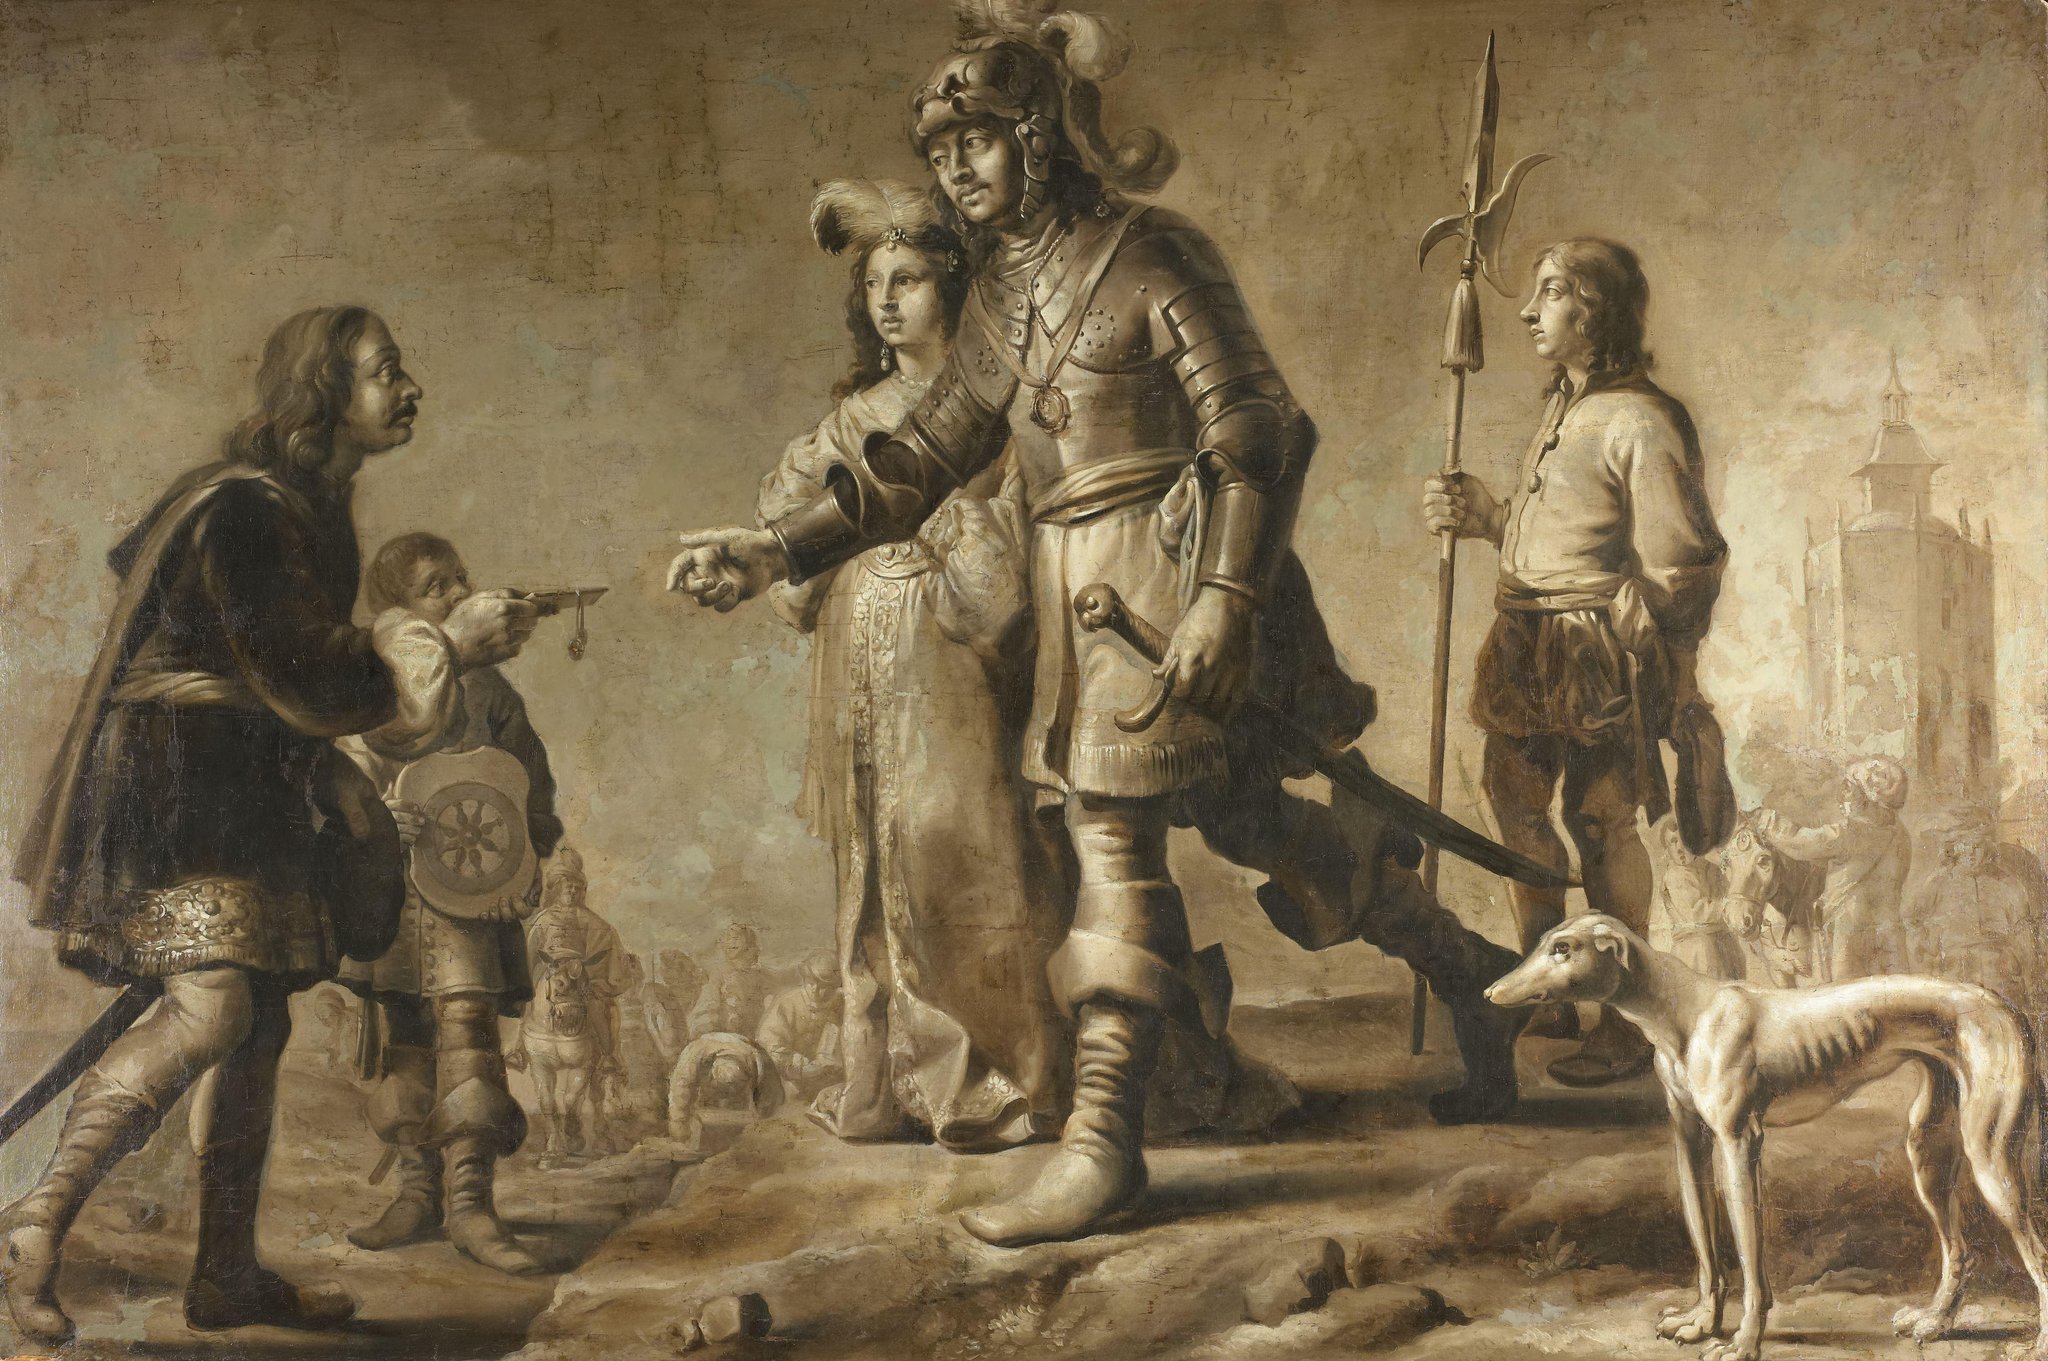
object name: painting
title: Boudewijn van Heusden (830-870) and his Wife Sophia Receiving Homage from the Legate of King Edmund, c. 1626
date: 1626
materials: canvas, oil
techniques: grisaille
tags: delivering; receiving (~ postal matter), historical persons - bb - woman, historical persons, kasteel oudheusden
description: Boudewijn van Heusden en zijn echtgenote Sophia, dochter van de Engelse koning Edmund, die eens door Boudewijn ontvoerd was, ontvangen eerbewijzen van de gezant van de Engelse koning Edmund. Links de boodschapper met een brief, in het midden Boudewijn in wapenrusting. Op de achtergrond Kasteel Oudheusden.